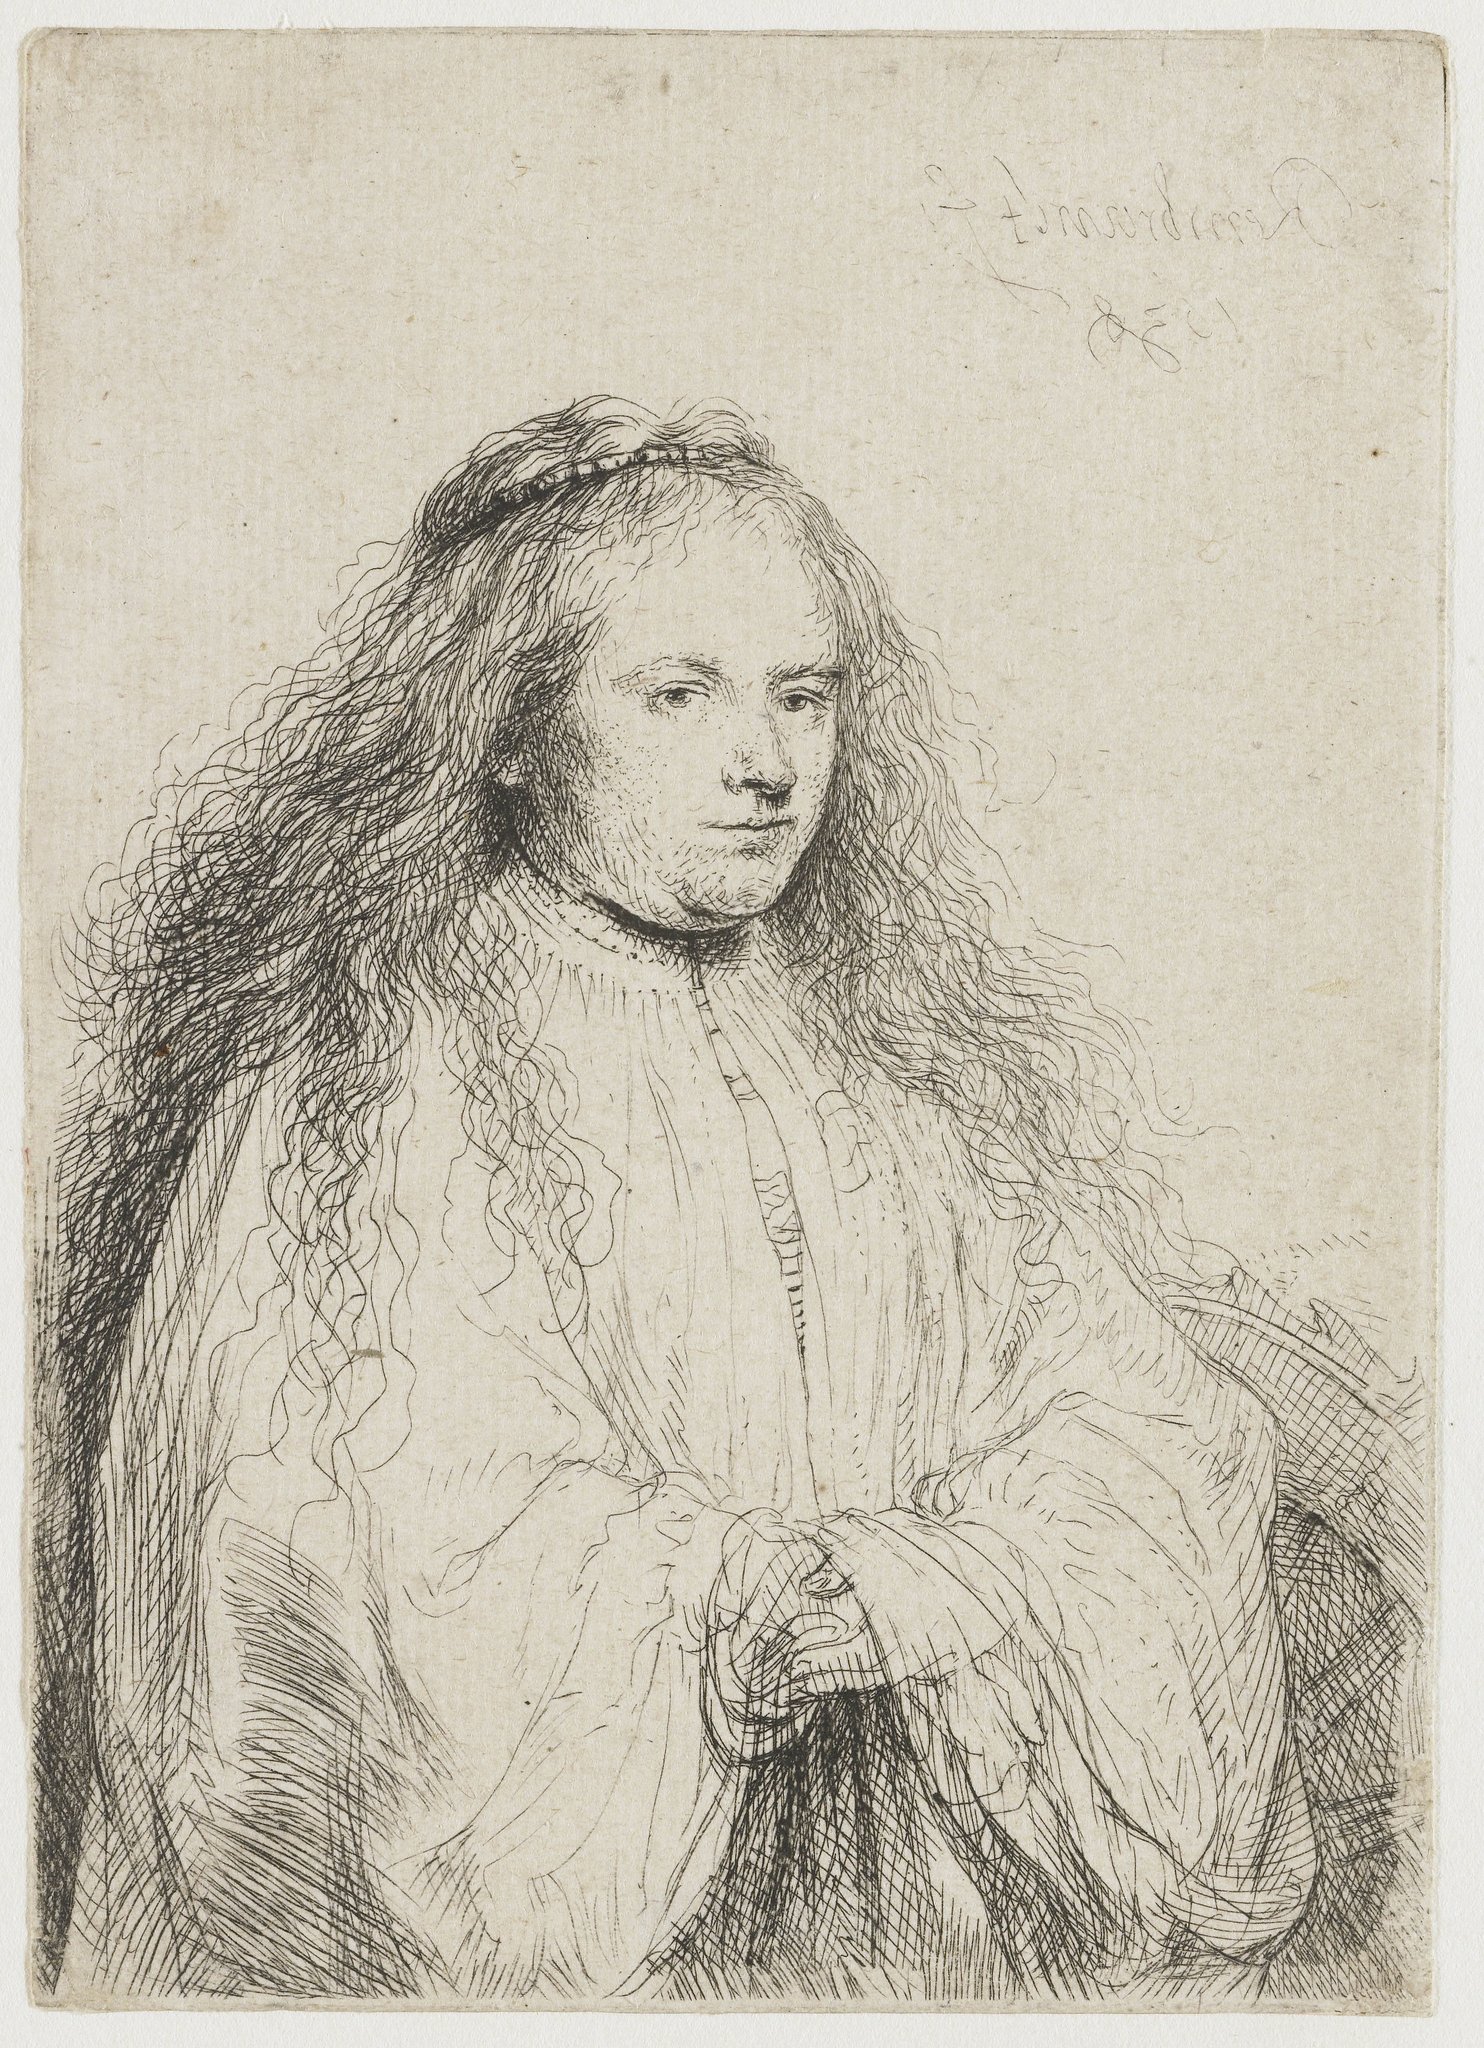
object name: print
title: St Catherine ('the little Jewish bride')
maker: rembrandt van rijn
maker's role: draughtsman, painter, print maker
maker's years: 1606-1669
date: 1638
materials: paper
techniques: drypoint, etching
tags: bride (in wedding-dress)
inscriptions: date